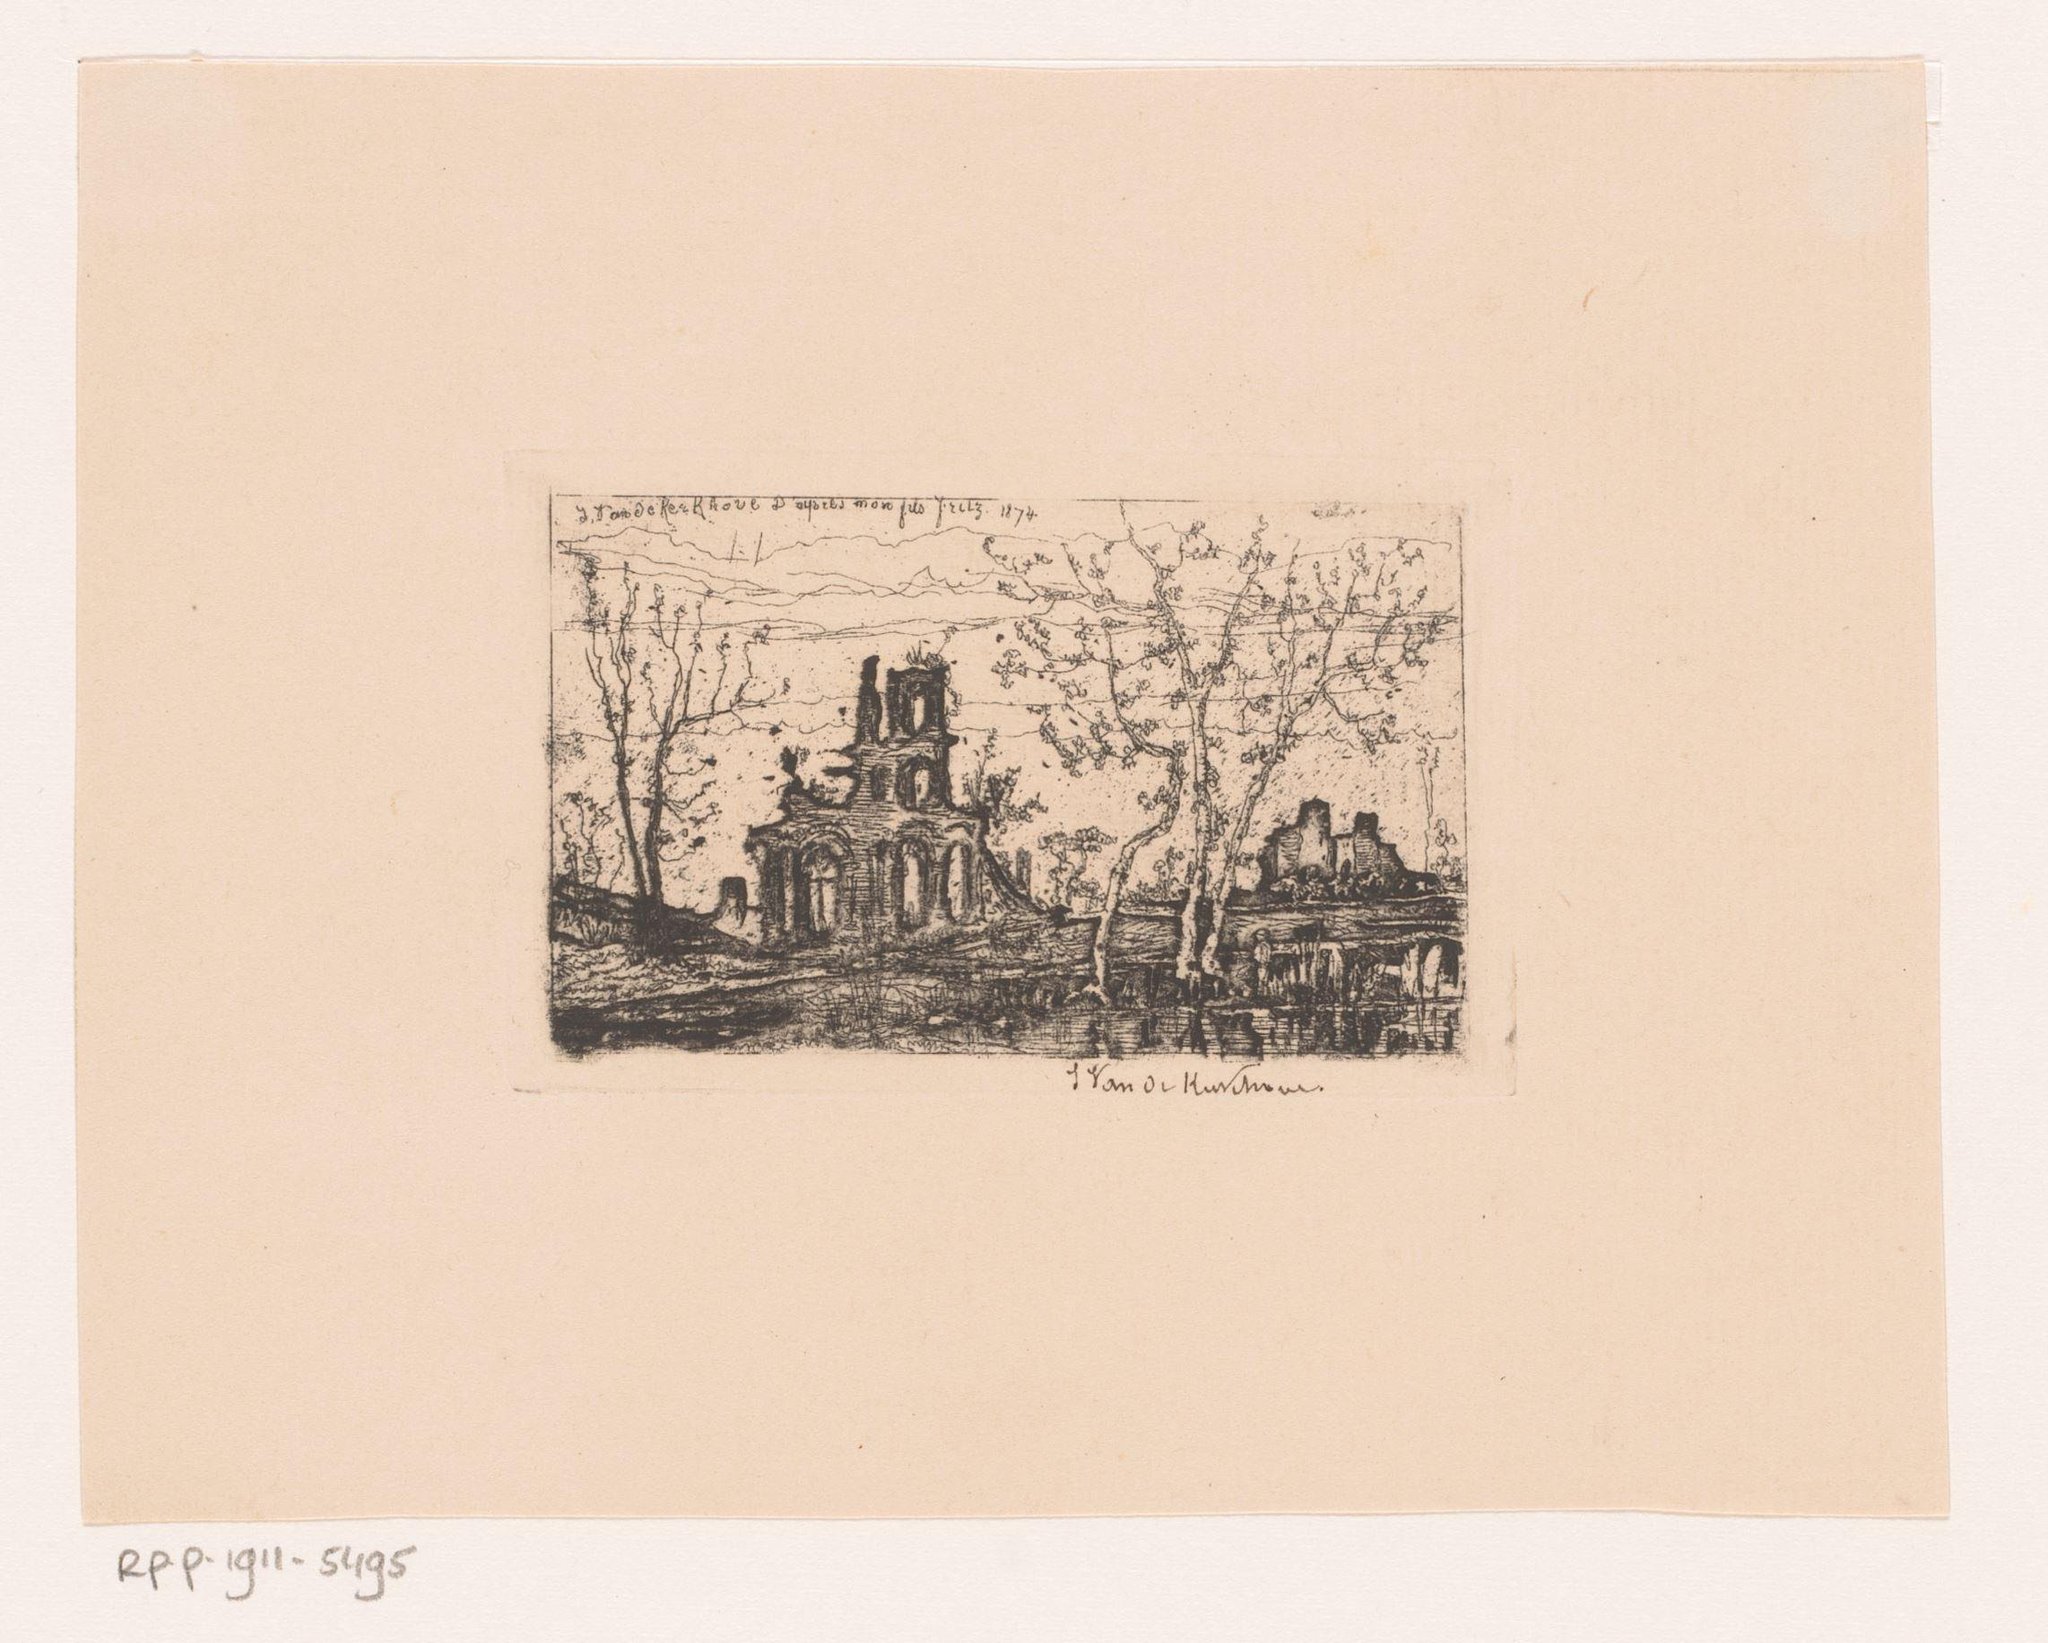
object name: print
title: Landschap met ruïne van een kerk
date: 1874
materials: paper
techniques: drypoint, etching, intaglio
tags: landscape with ruins, ruin of church, monastery, etc.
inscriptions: collector's mark: Lugt 2228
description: De etsen naar de schilderijen van Frédéric Van de Kerkhove werden na zijn dood door zijn vader en zuster gemaakt en uitgegeven in twee reeksen. De eerste werd in 1877 uitgegeven door het Journal des Beaux-Arts et de la Littérature: Cahier de 25 Eaux-fortes d'après Frédéric van de Kerkhove, gravées par son père et sa sœur. De tweede reeks van 126 etsen, ook in 1877, werd in Parijs uitgegeven bij A. Lévy onder de titel Cent eaux-fortes gravées par J. Van de Kerkhove d'après les tableaux de Frédéric Van de Kerkhove, mort en 1873 à l'âge de 10 ans et 11 mois.